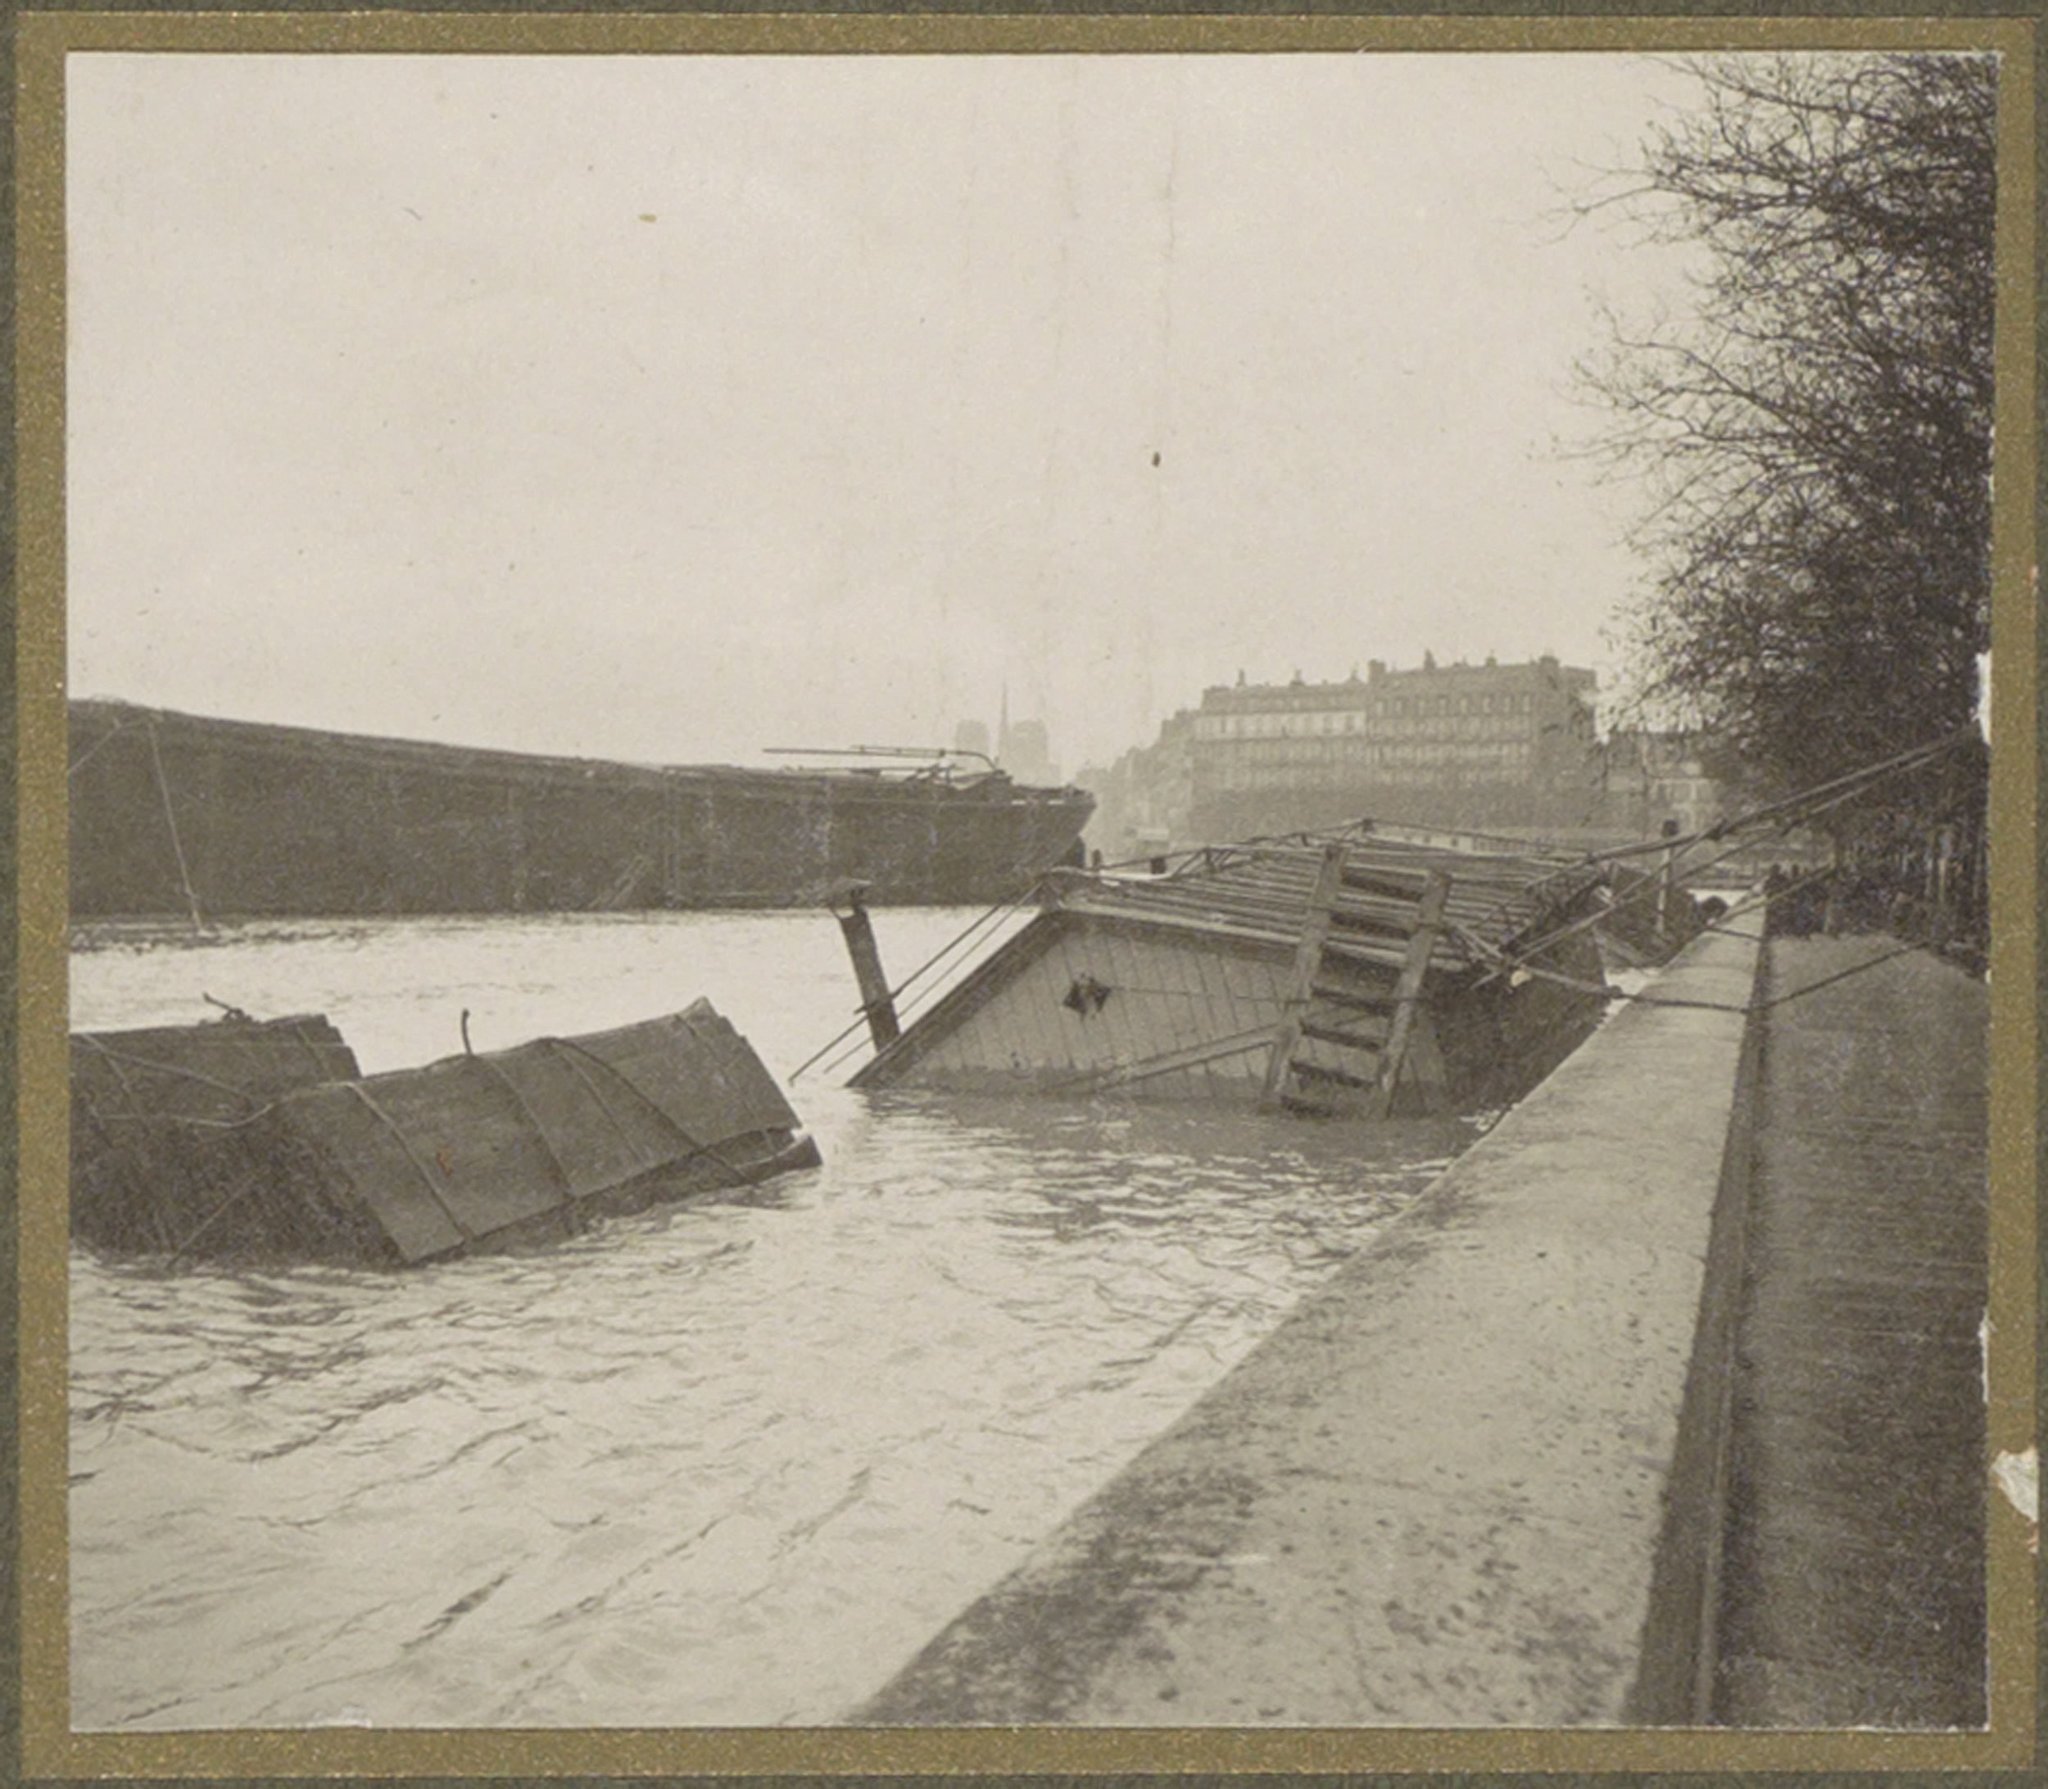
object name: photograph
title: Gezonken boot aan de Seine-oever tijdens de overstroming van Parijs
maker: g. dangereux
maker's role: fotograaf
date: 1901-1910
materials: photographic support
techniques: matte daylight collodion silver print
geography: paris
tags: flood (+ landscape with figures, staffage), pier, quay, wharf, paris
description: Onderdeel van fotoalbum overstroming Parijs en voorsteden 1910.